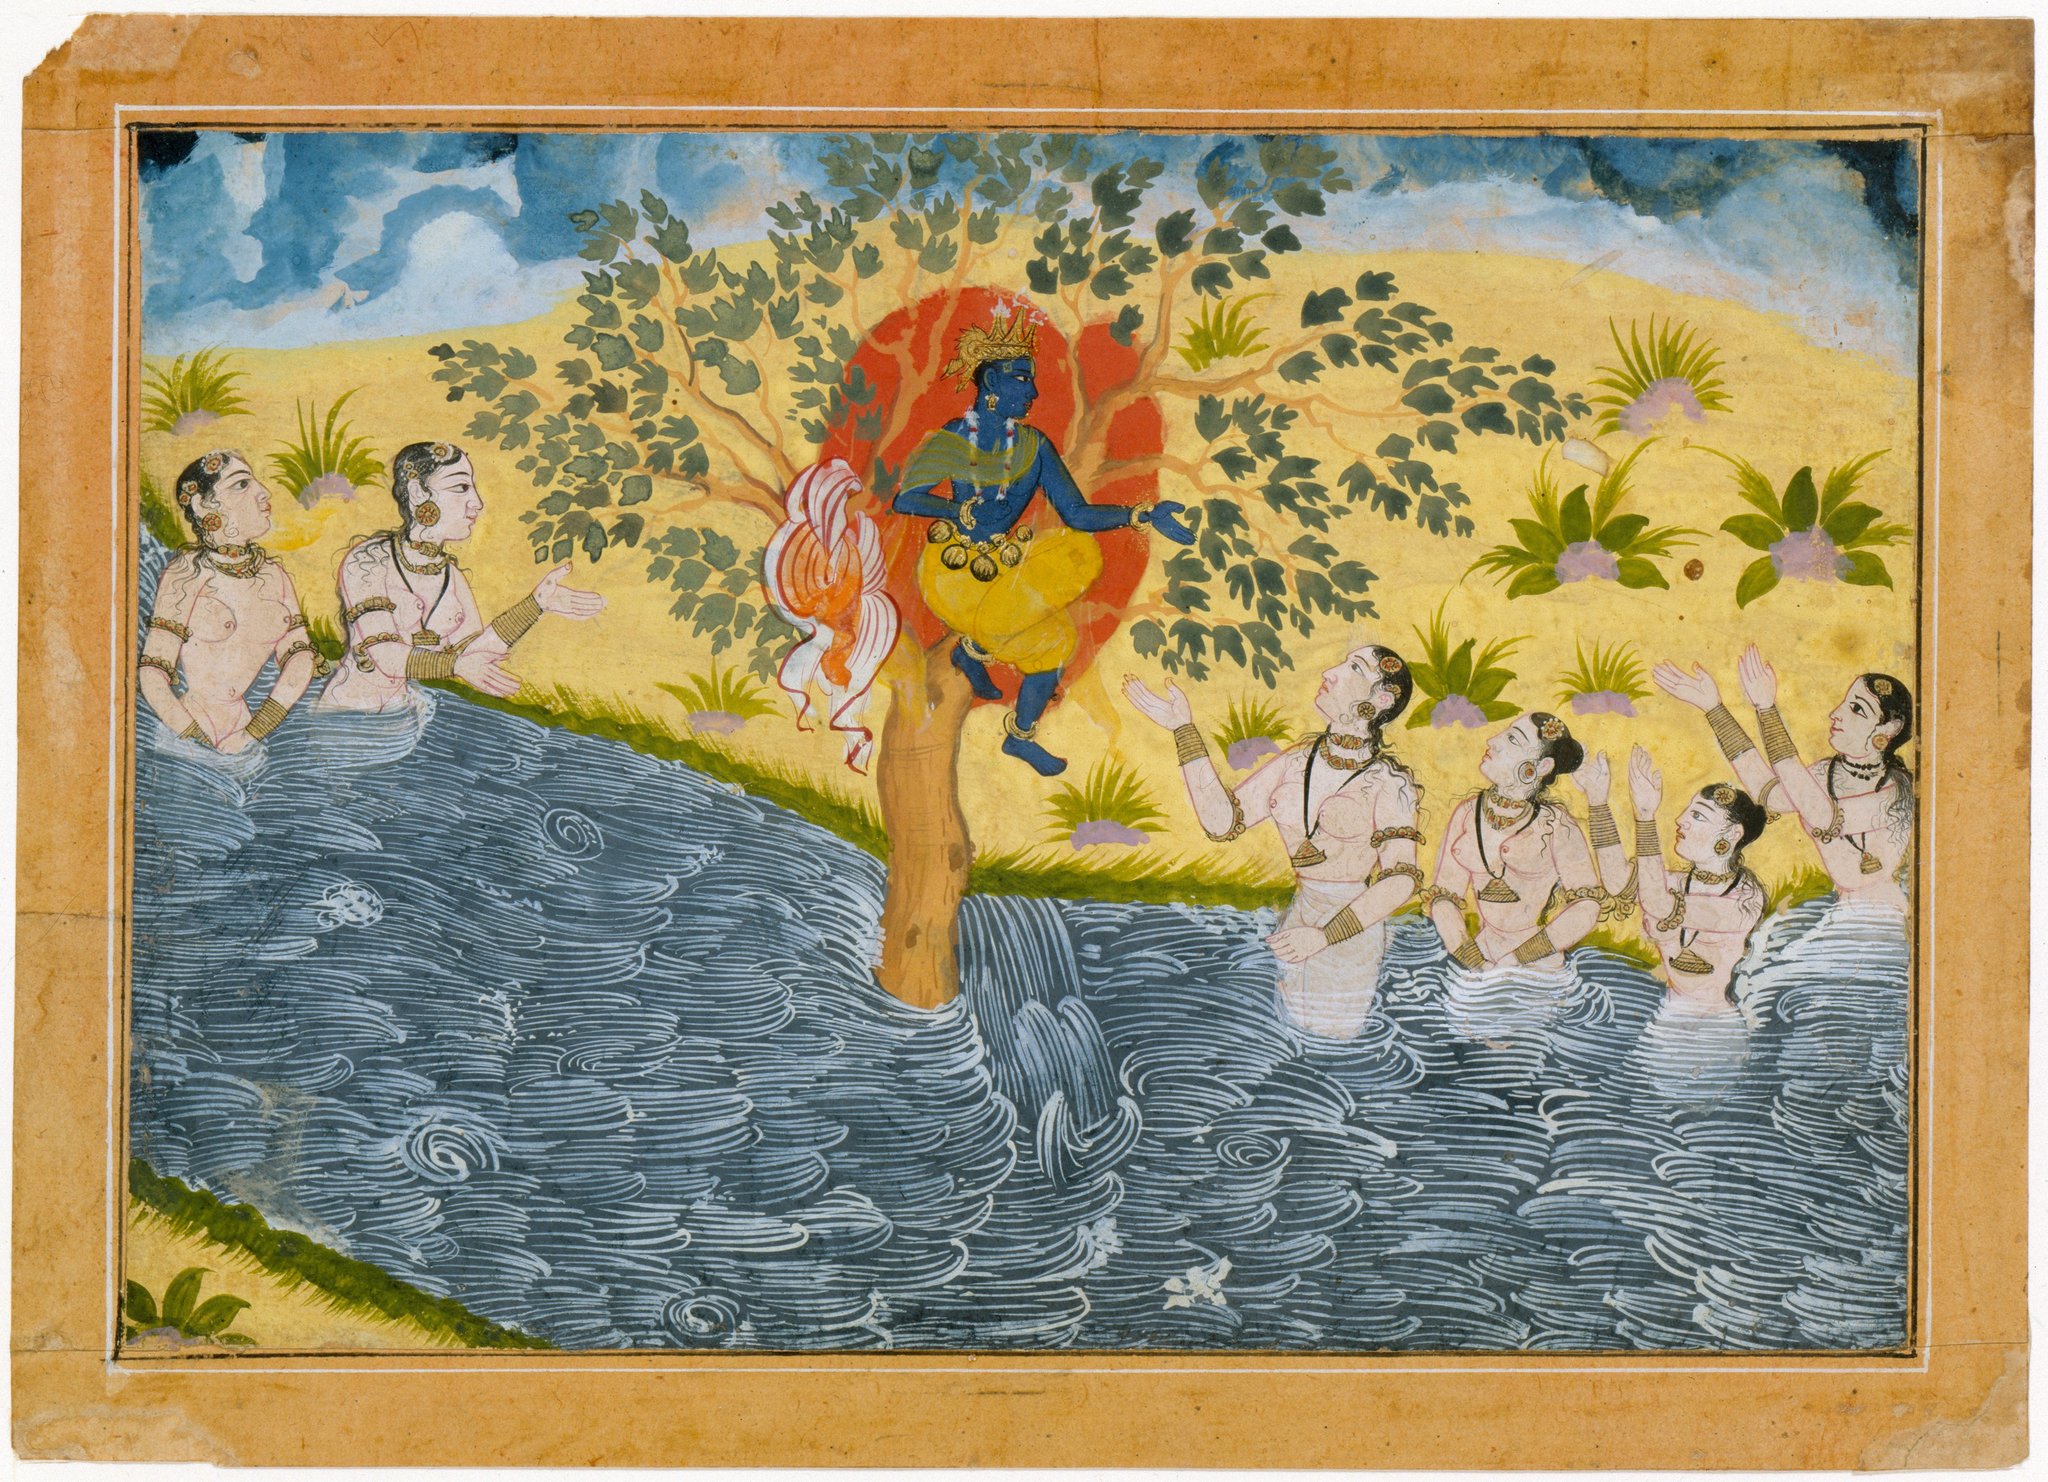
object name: page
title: The Gopis Plead with Krishna to Return Their Clothing, Page from a Bhagavata Purana (Ancient Stories of Lord Vishnu) series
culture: indian, rajasthani, bikaner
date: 1610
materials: gold, ink, paper, watercolor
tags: women,krishna,bathing